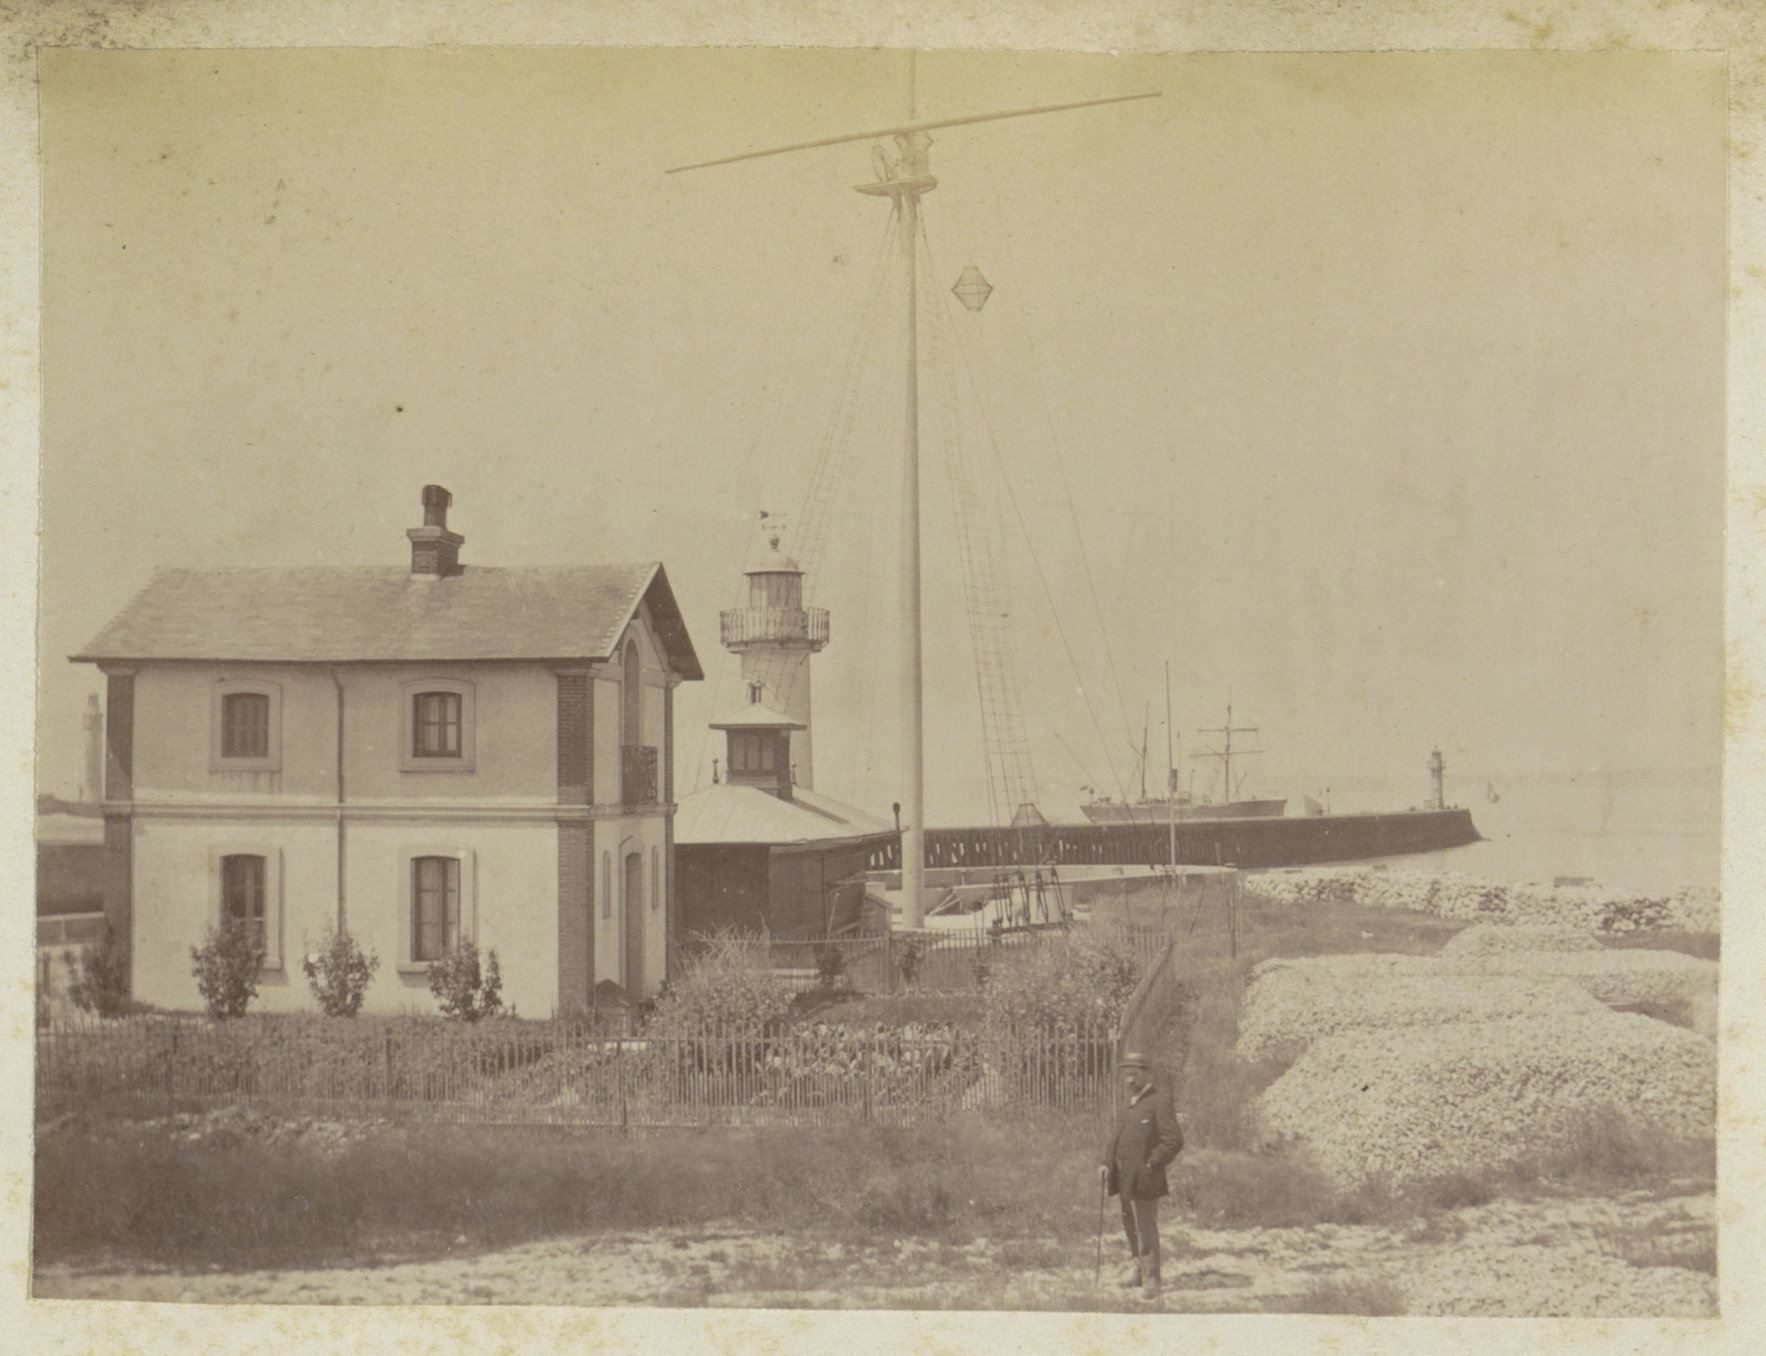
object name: photograph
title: Pier, vuurtoren en (mogelijk) seinpost in de haven van Honfleur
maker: Anonymous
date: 1806-1885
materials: photographic support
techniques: albumen print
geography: honfleur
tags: lighthouse, lightship, pier, quay, wharf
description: Onderdeel van Album van een Franse amateurfotograaf met opnames van familie, militairen, industrie, landschappen en bezienswaardigheden in Frankrijk.